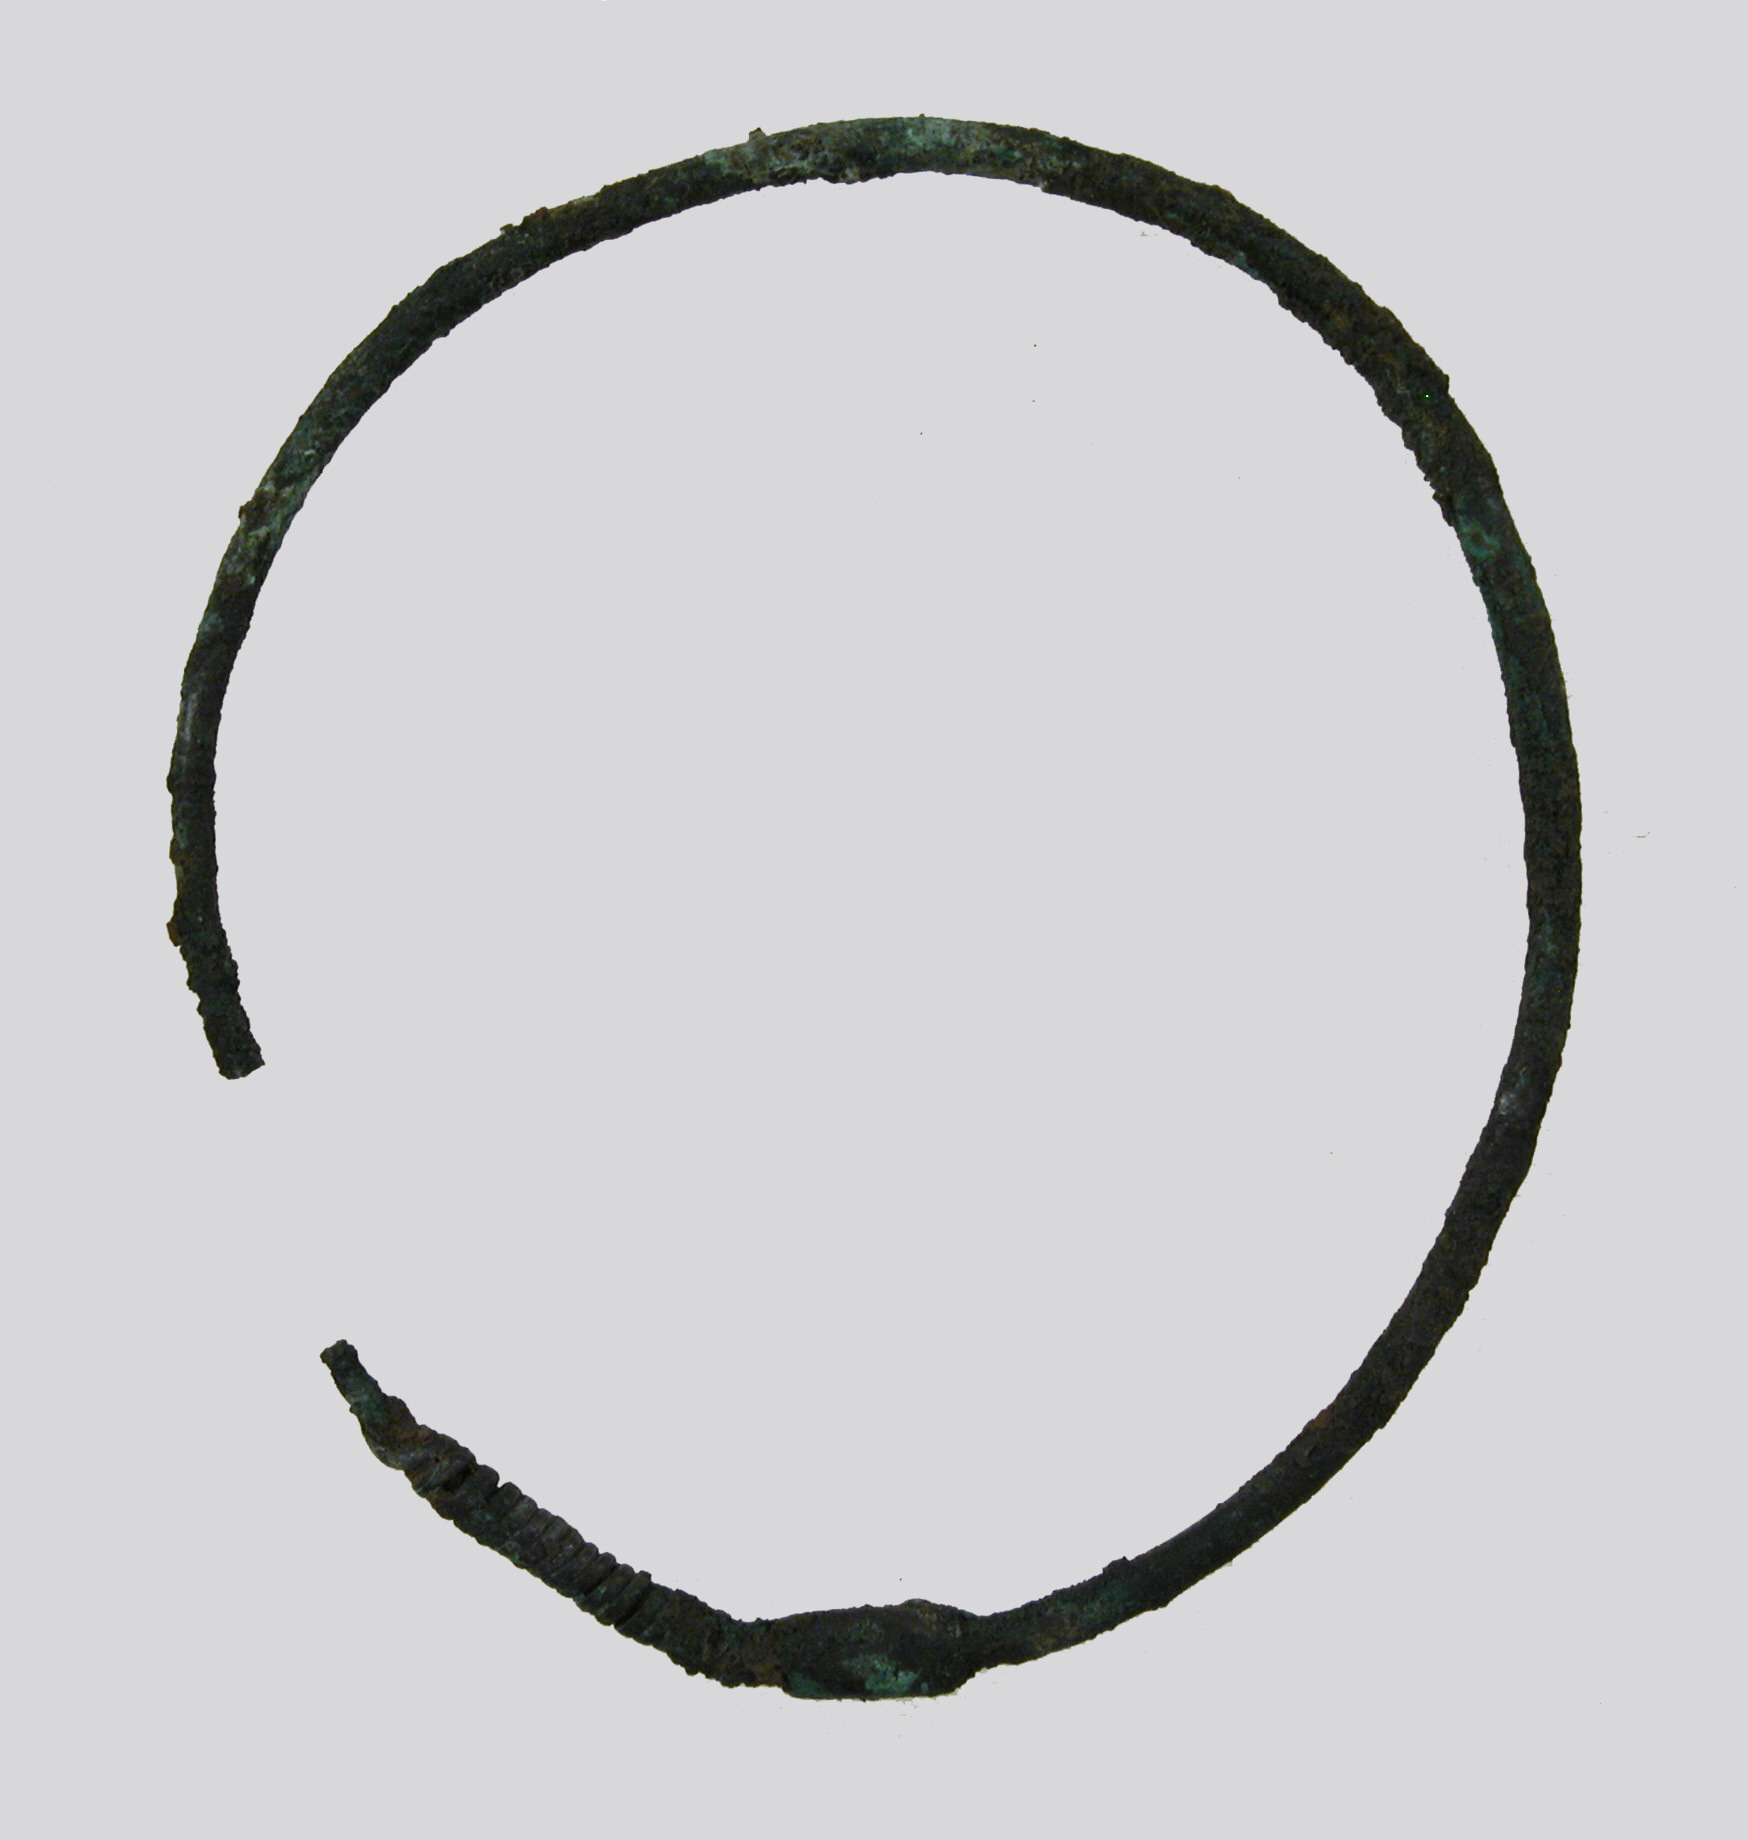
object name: earring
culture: frankish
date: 601-700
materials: silver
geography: germany